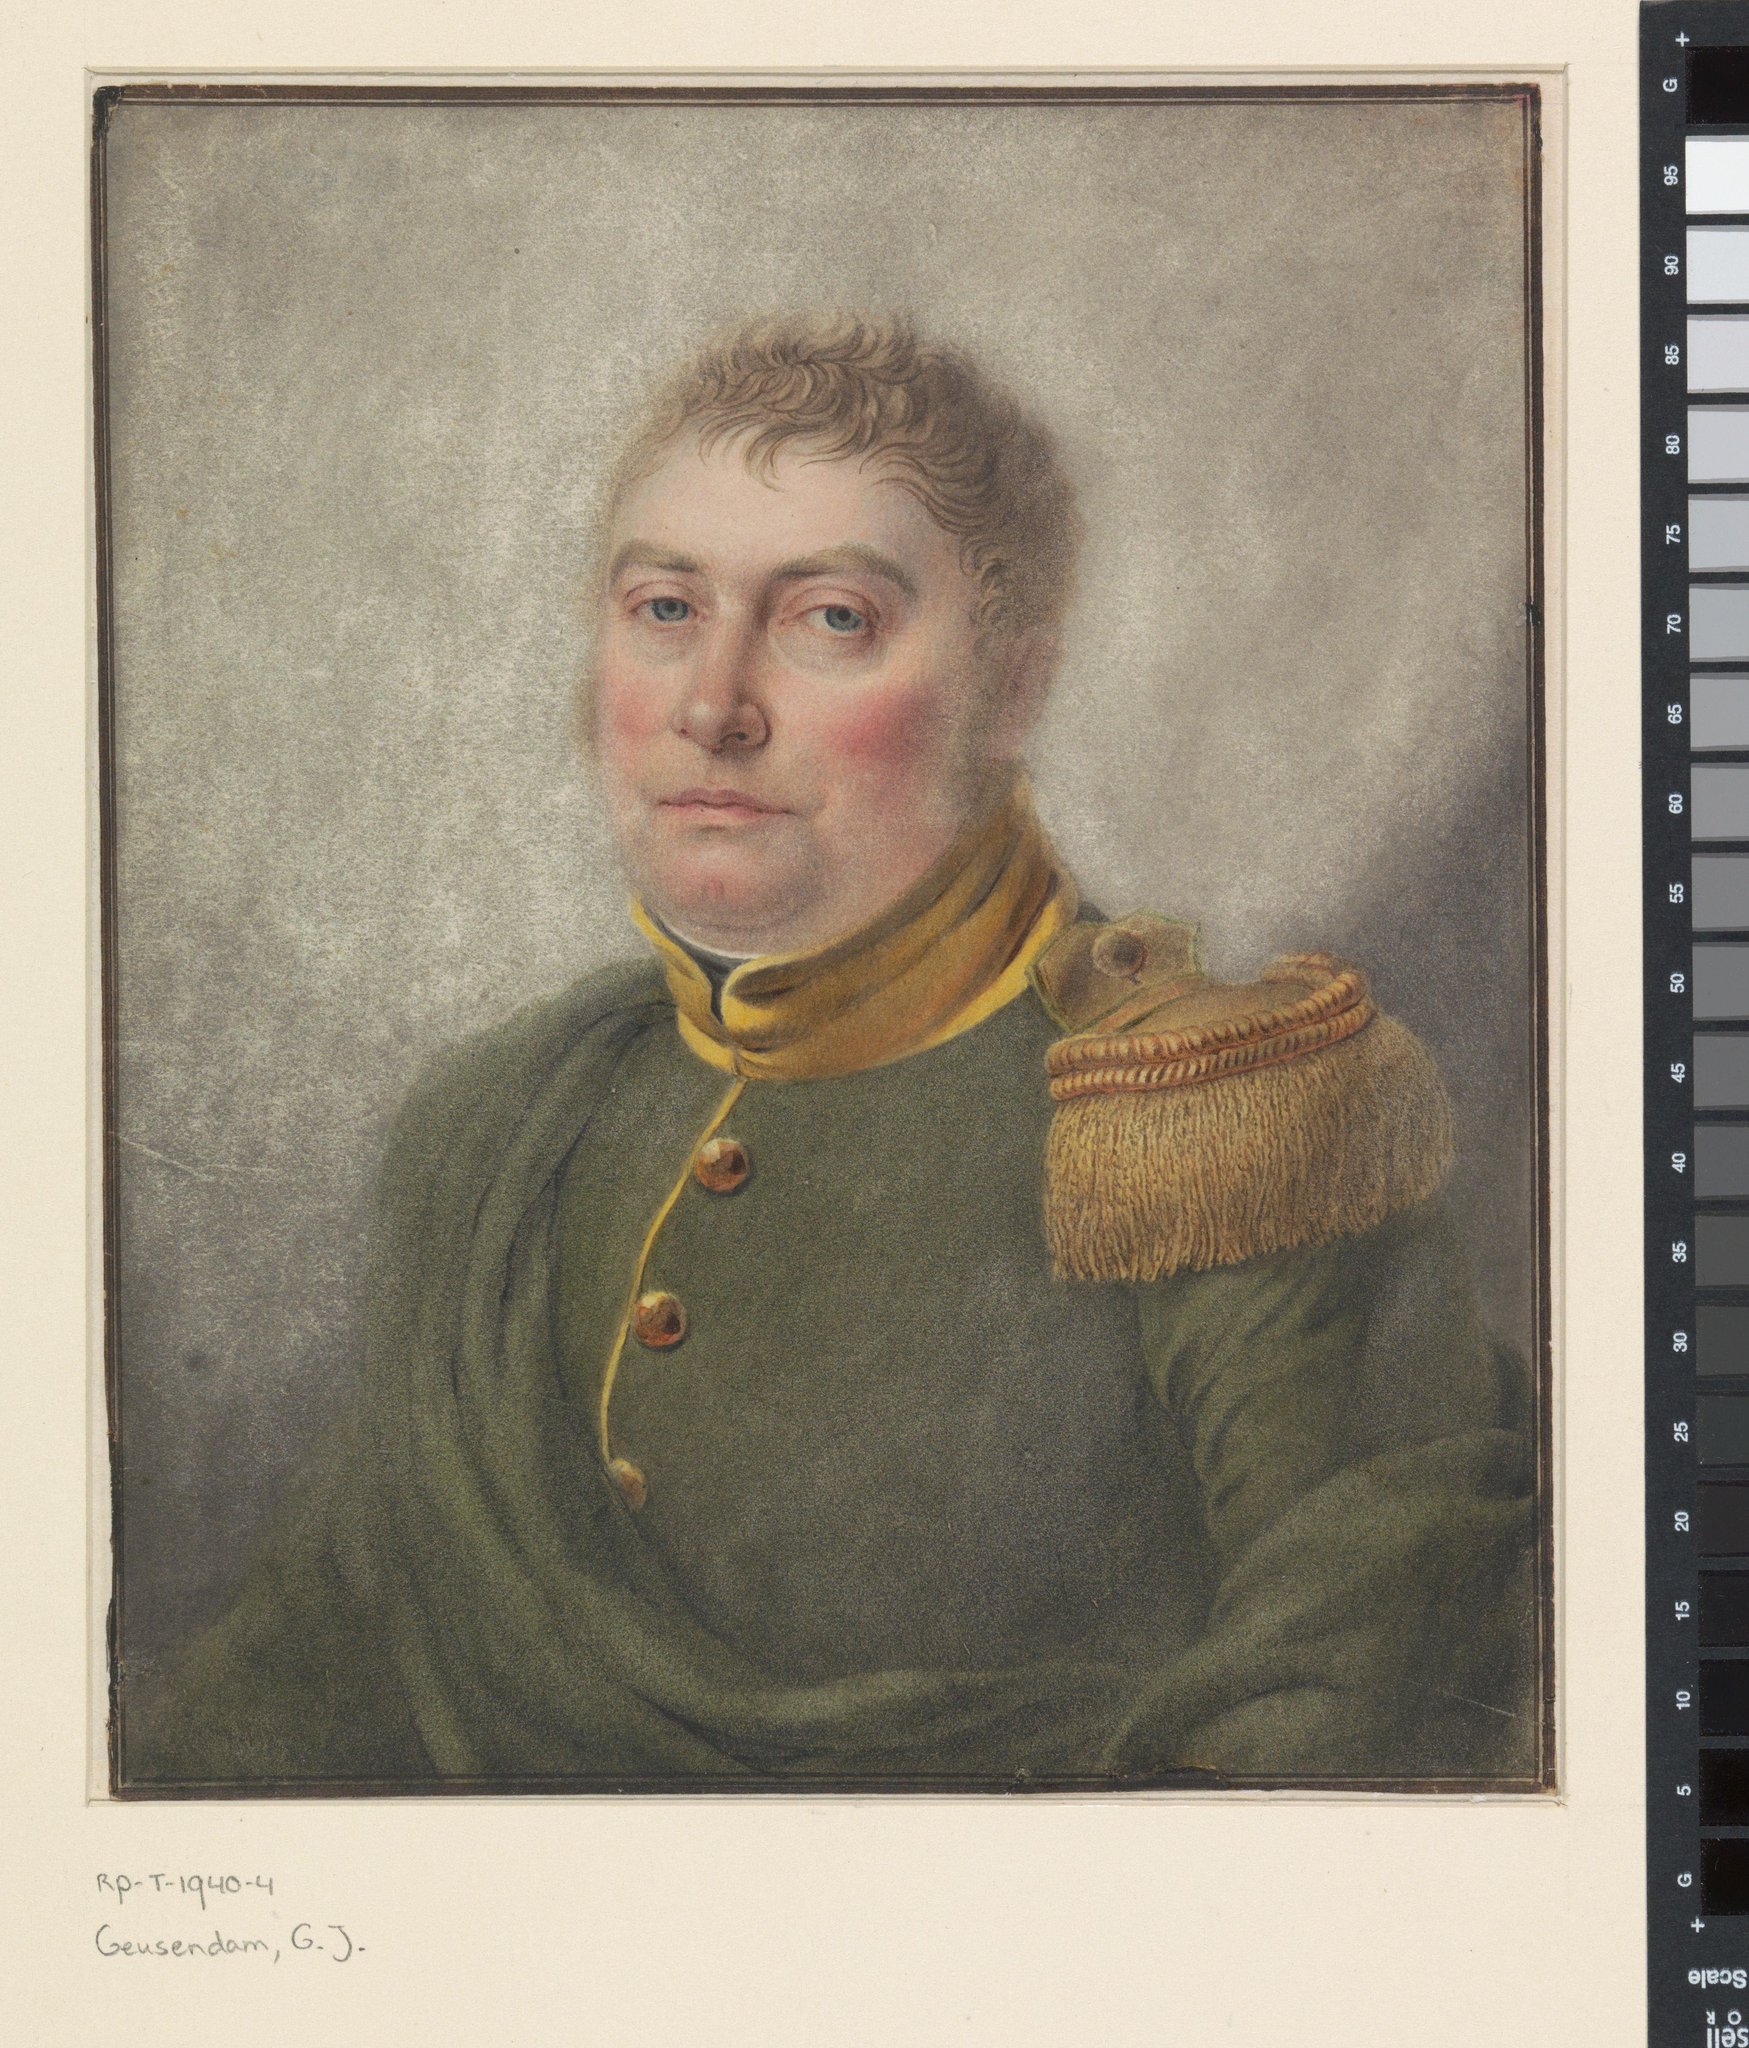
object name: watercolor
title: Portret van E.W.G. Bagelaar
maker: gerrit jacobus geusendam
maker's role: draughtsman, painter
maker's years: 1771-1842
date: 1781-1815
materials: paper, watercolor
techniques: brush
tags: print maker, ernst willem jan bagelaar, historical persons, portrait, self-portrait of artist